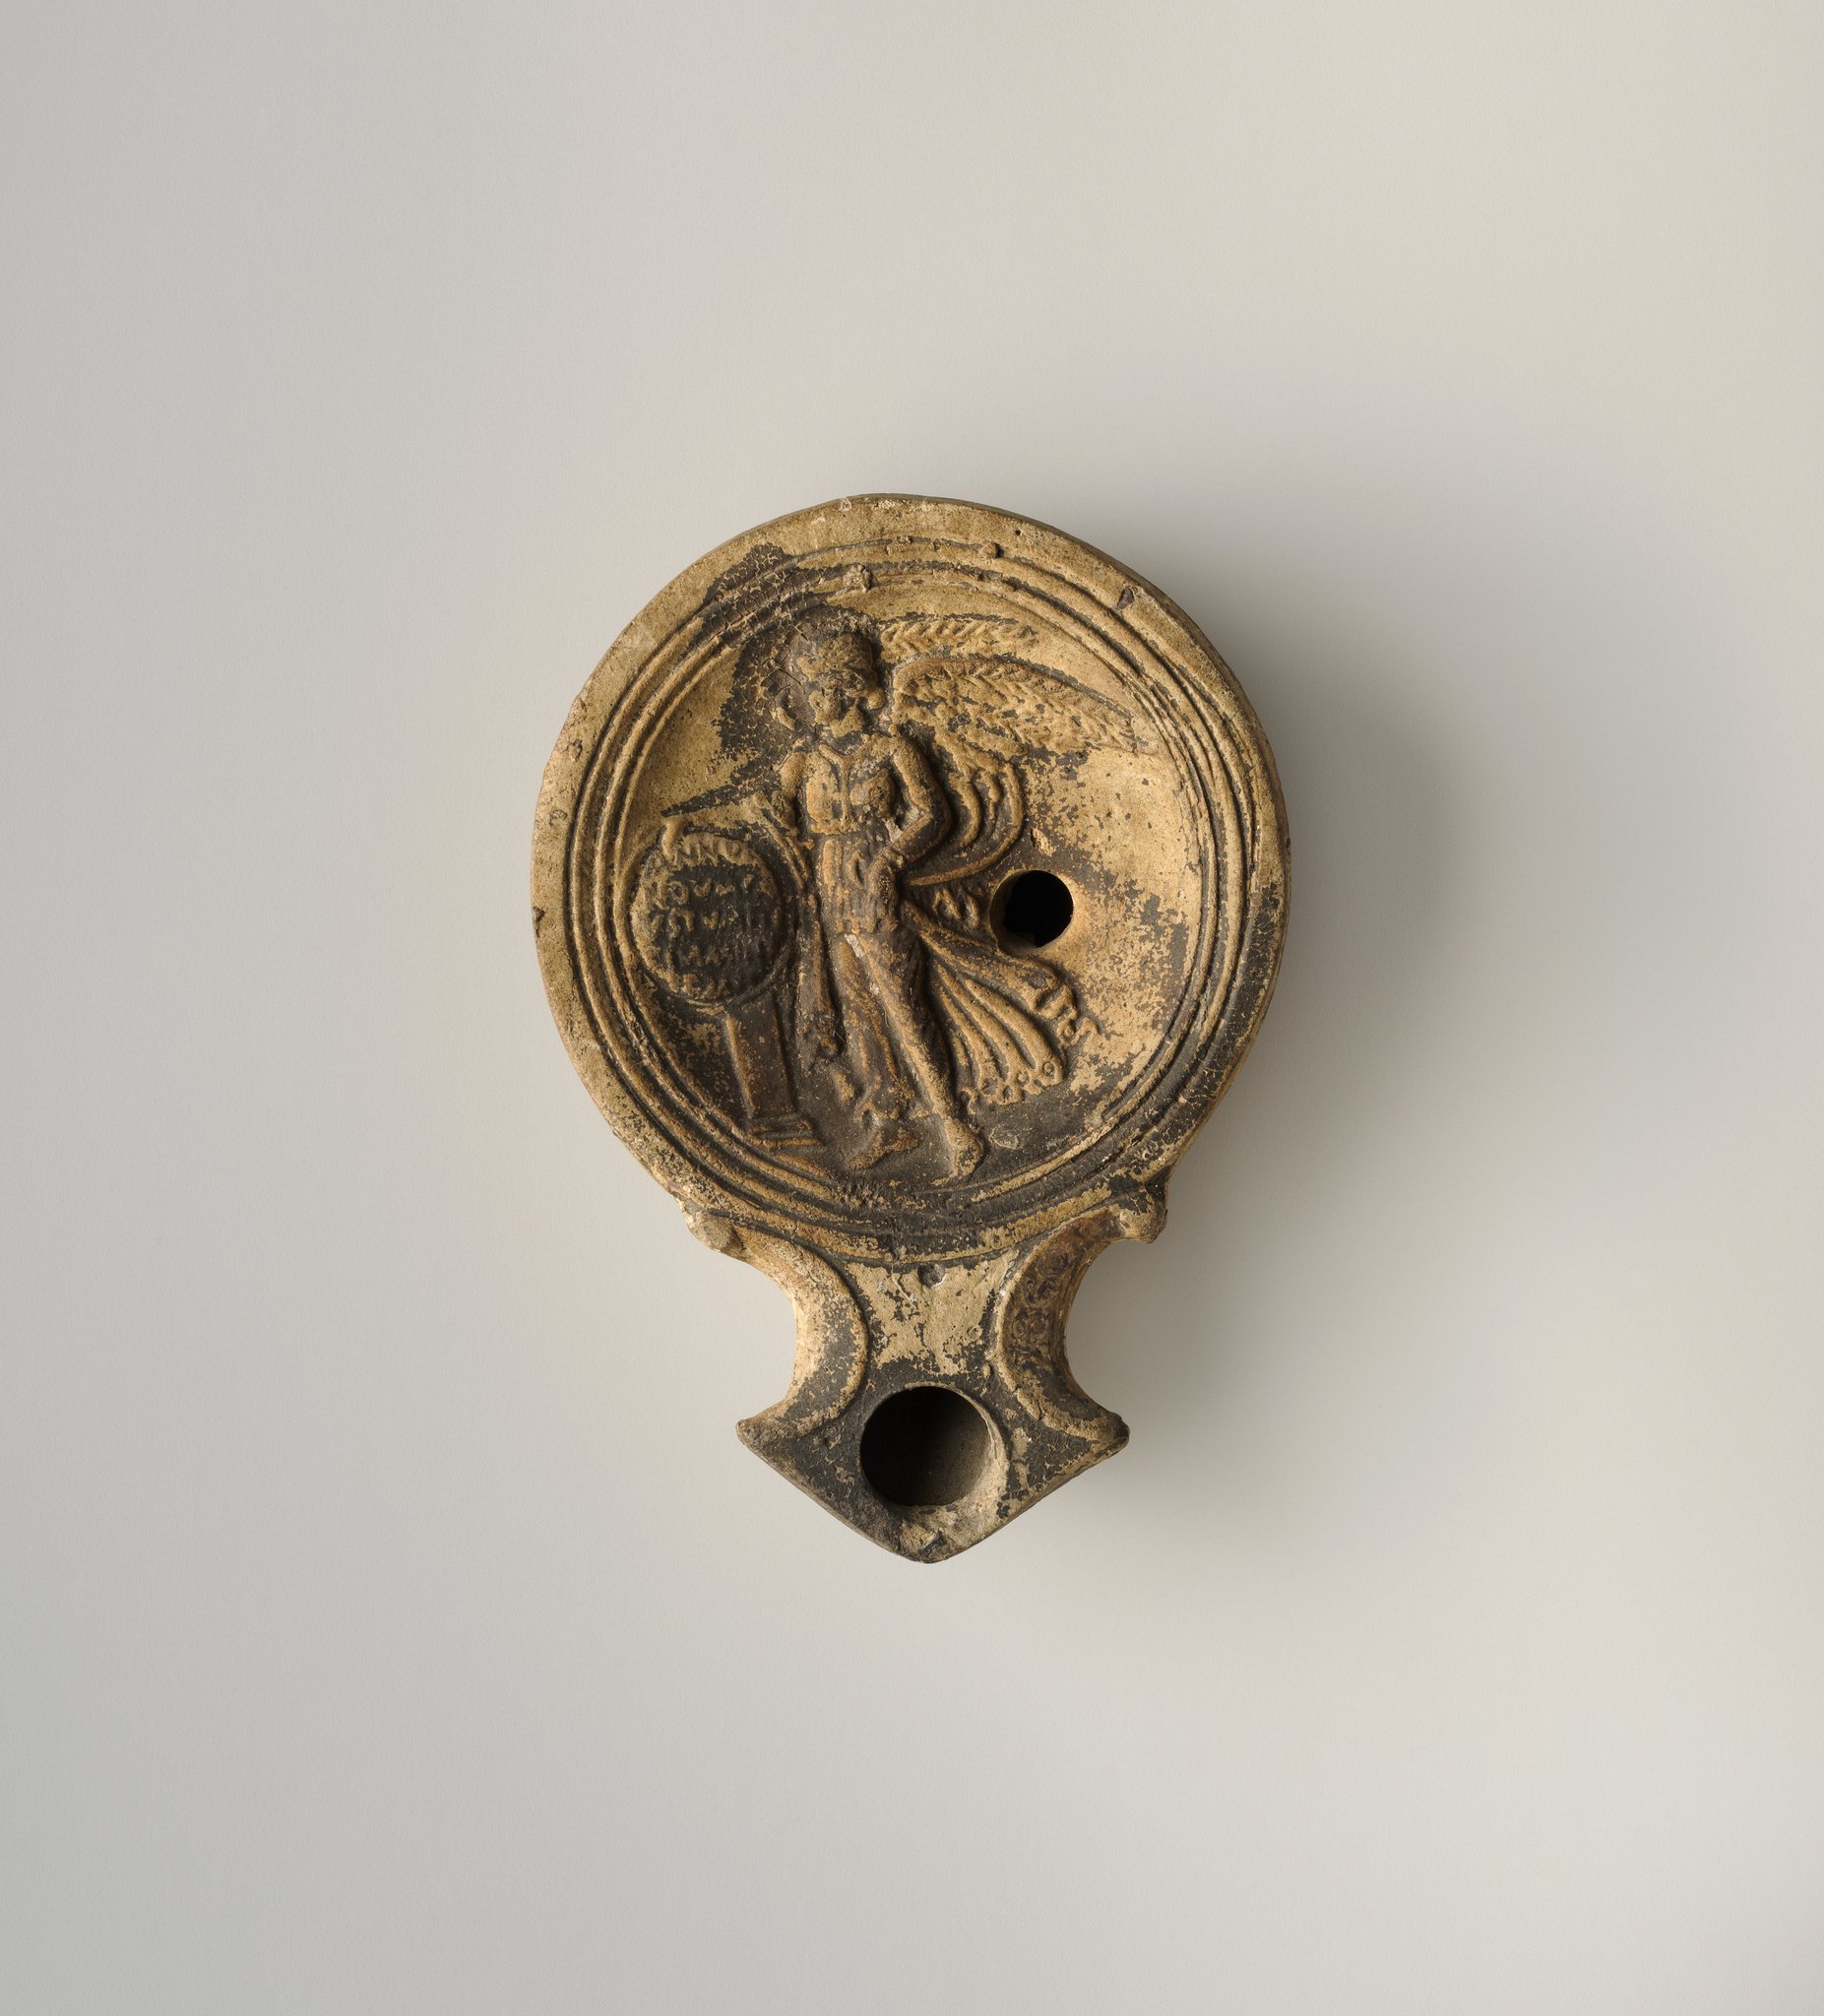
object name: lamp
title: Terracotta oil lamp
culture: roman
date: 1-50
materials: terracotta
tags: victory